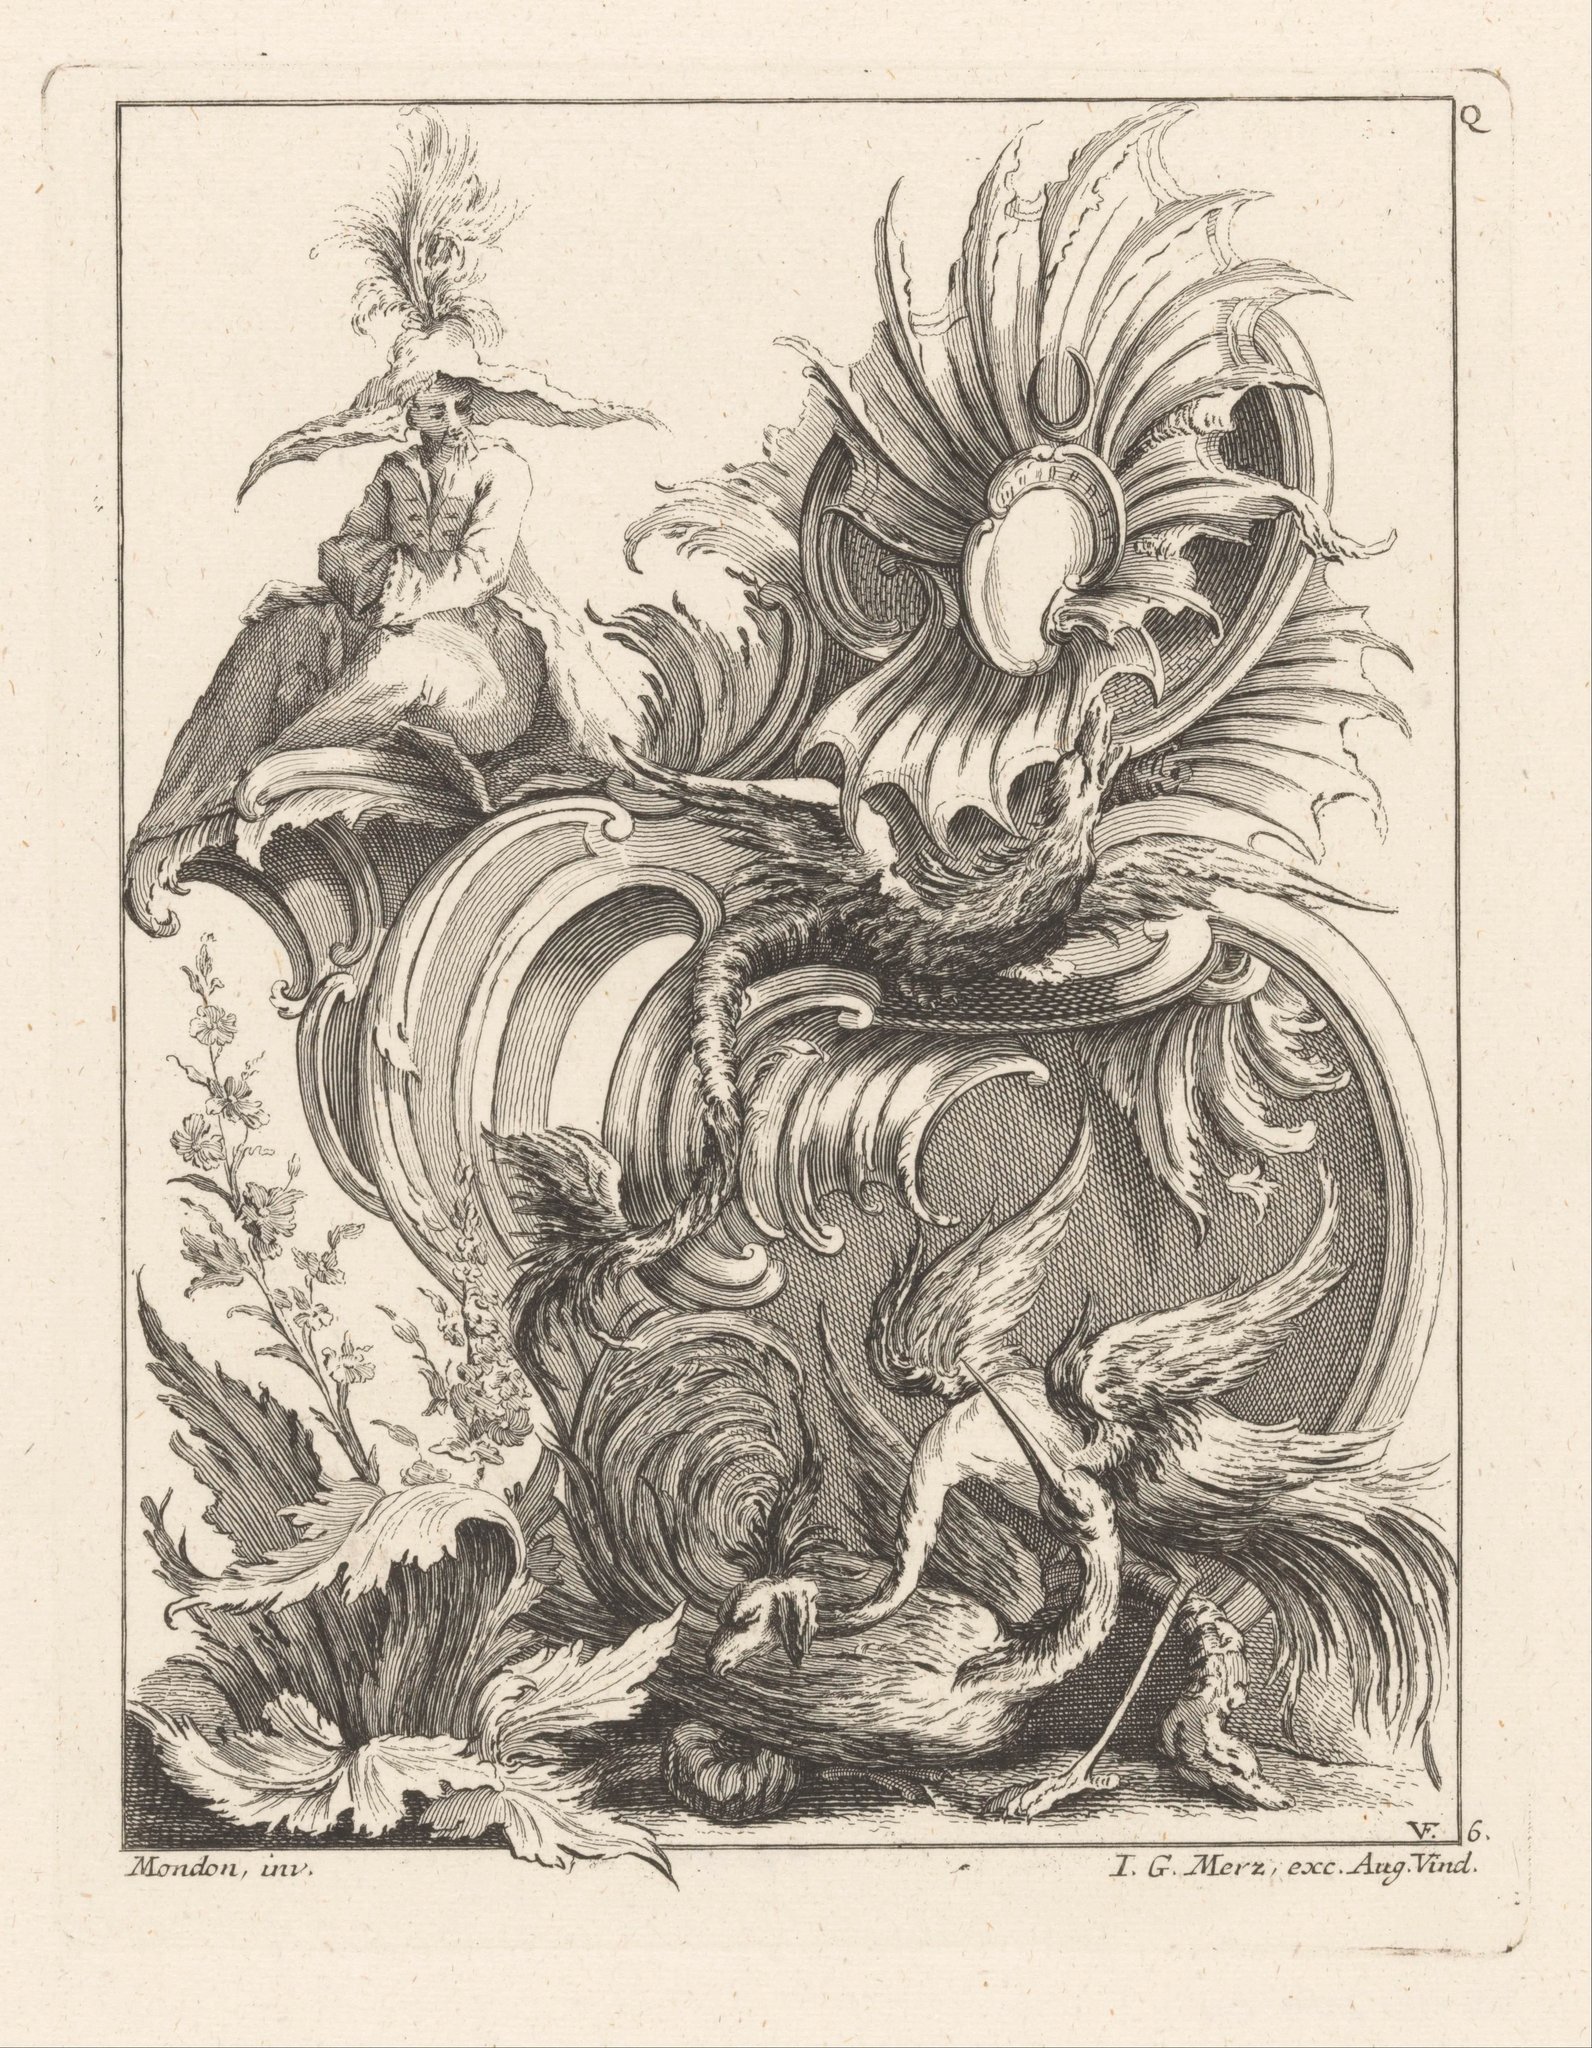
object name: ornament print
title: Rocaille en fantasiedieren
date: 1736-1762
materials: paper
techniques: etching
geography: augsburg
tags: rocaille ornament, fabulous animals (sometimes wrongly called 'grotesques'); 'mostri' (ripa)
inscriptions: collector's mark: Lugt 2228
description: Links op een rocaille zit een oosterse man met grote hoed. In het midden en rechts onder drie fantasiedieren.